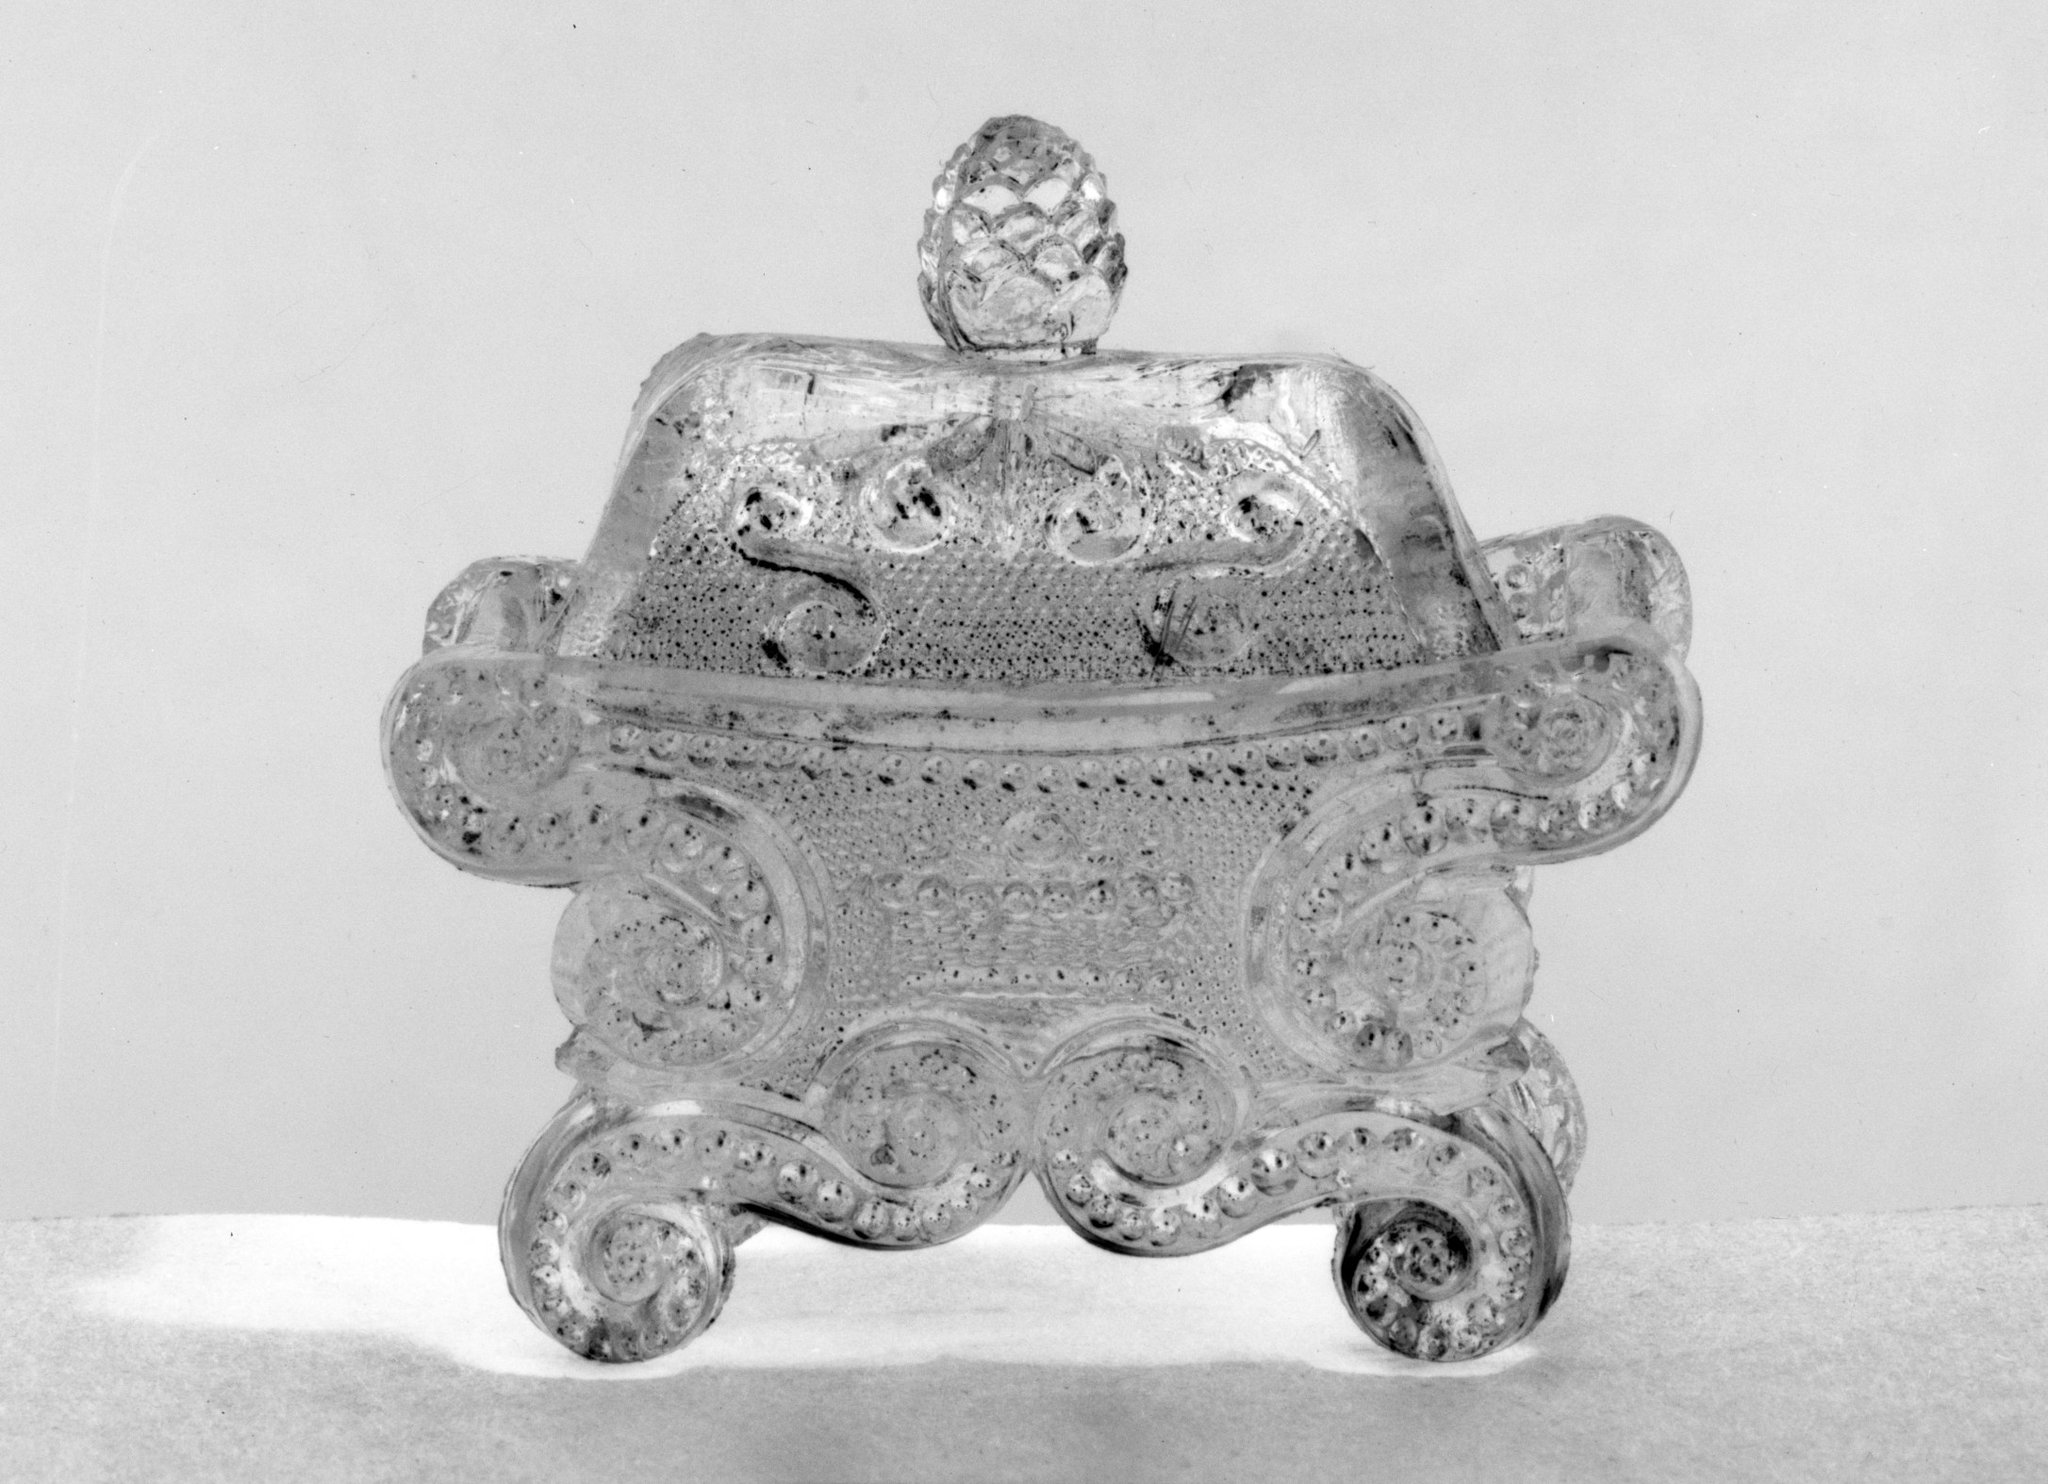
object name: saltcellar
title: Covered Saltcellar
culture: american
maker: boston & sandwich glass company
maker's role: maker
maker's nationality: american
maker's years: 1825-1888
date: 1835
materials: glass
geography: united states